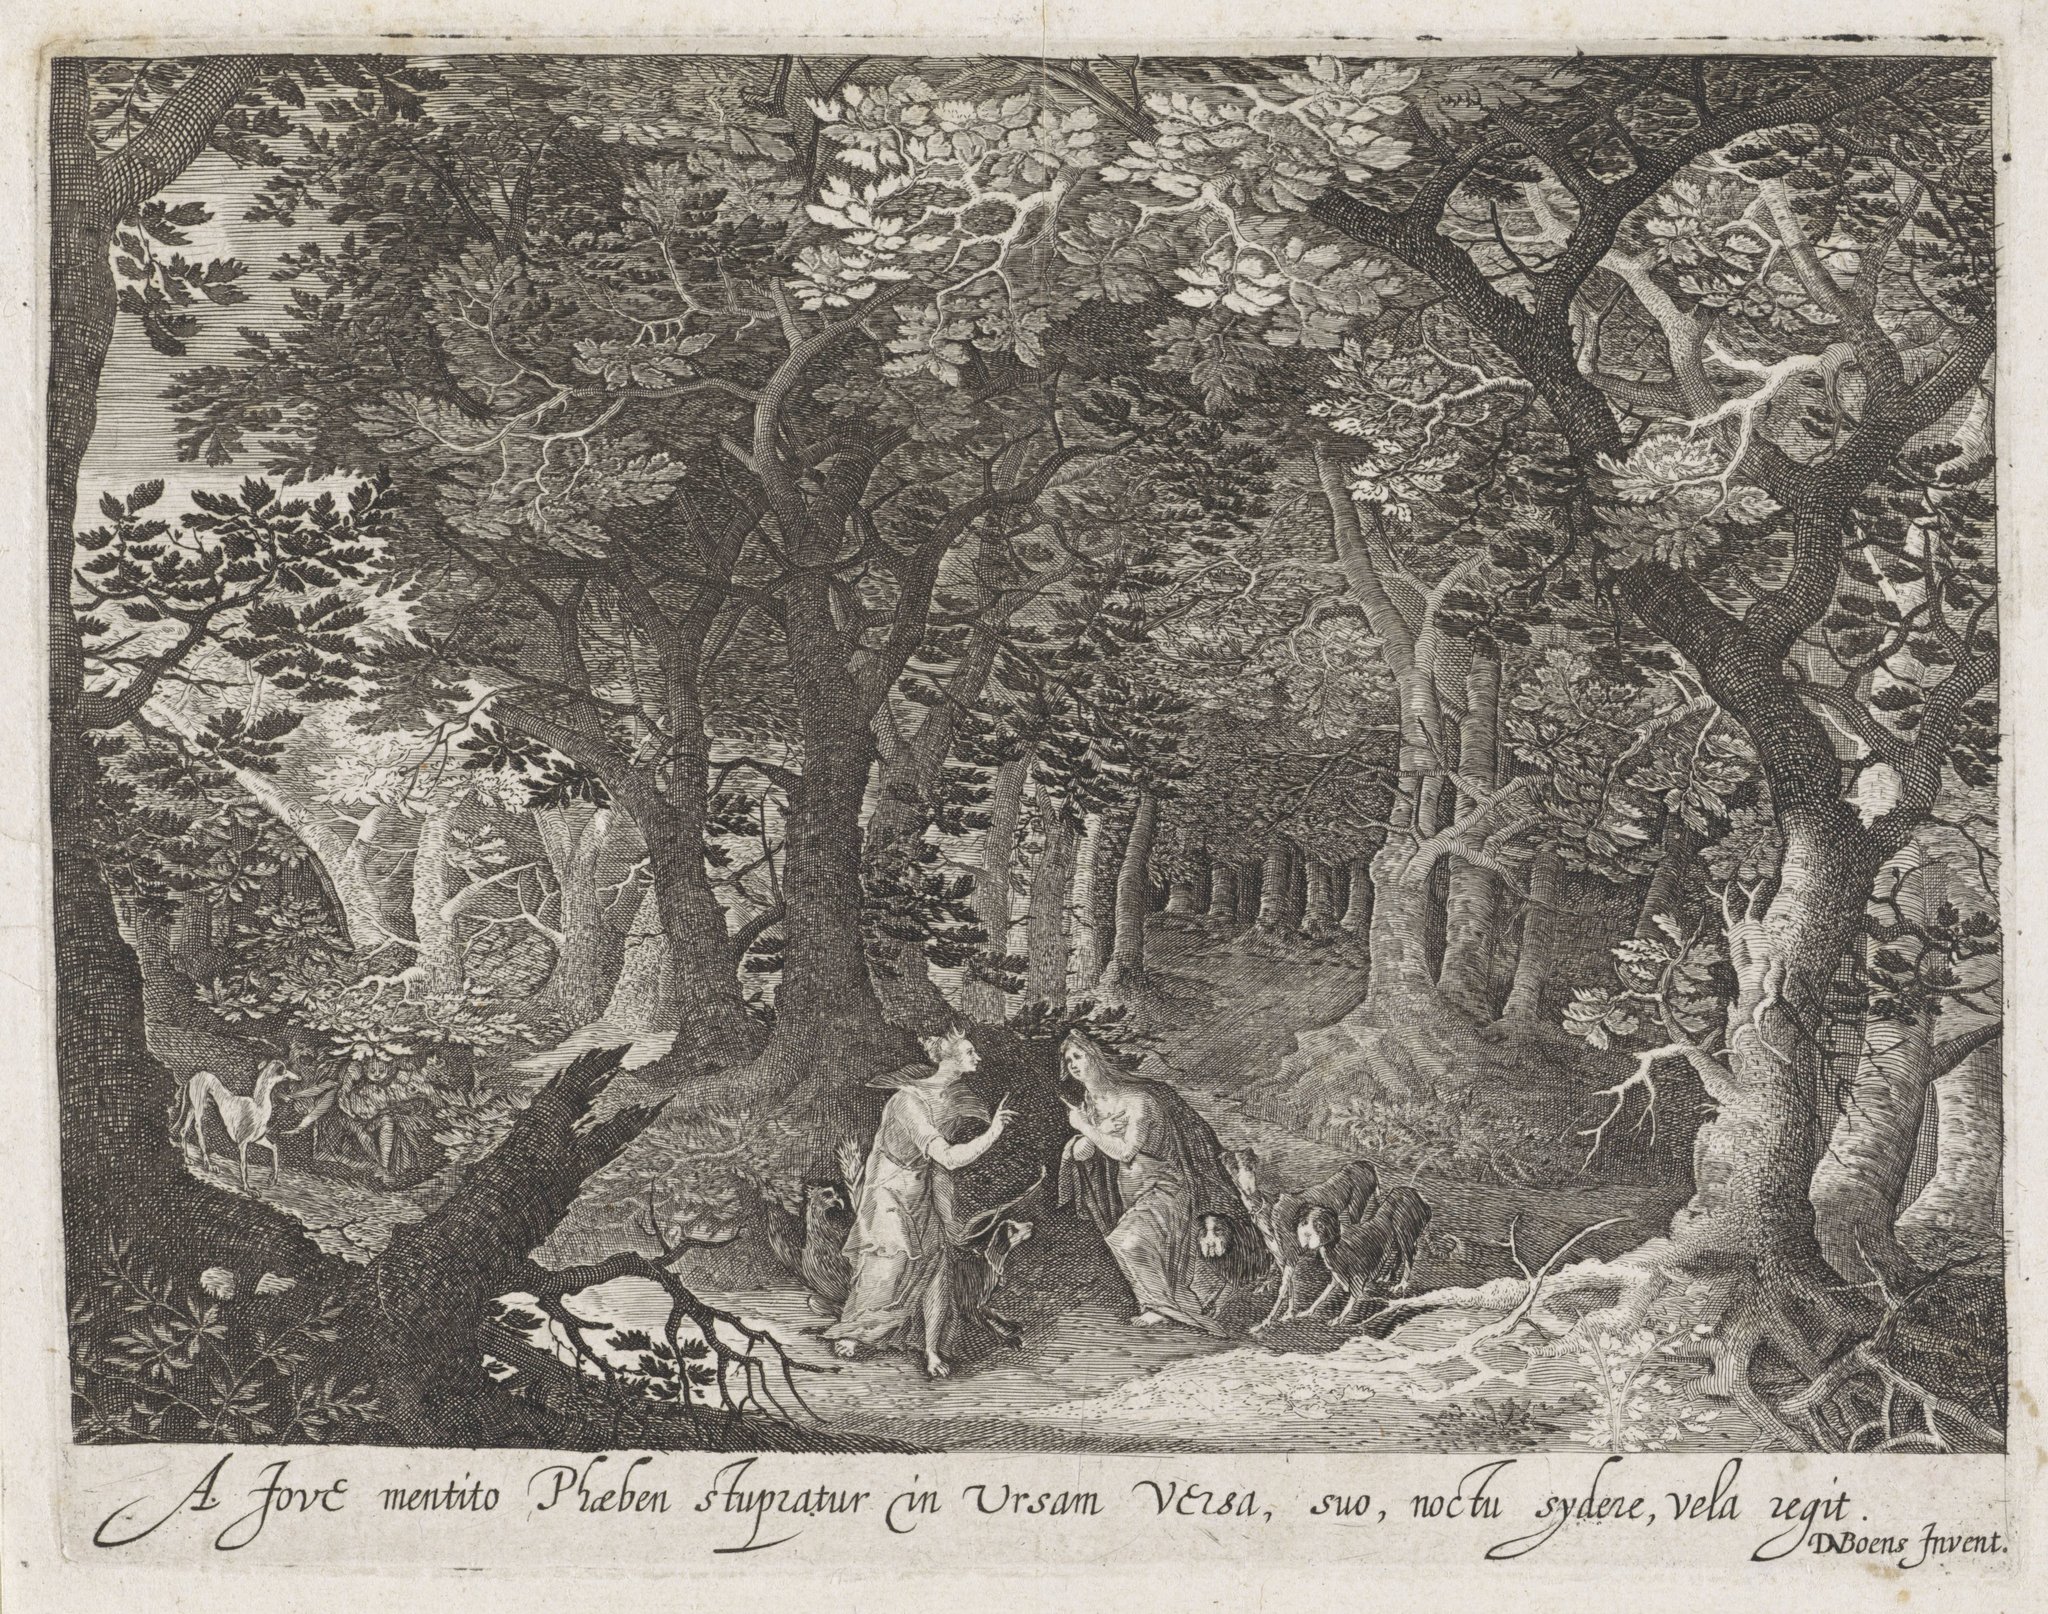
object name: print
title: Jupiter en Callisto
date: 1591-1679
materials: paper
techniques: engraving, etching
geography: low countries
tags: jupiter, in the guise of diana, and callisto, homosexual love - cc - homosexual love between women: lesbianism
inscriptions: collector's mark: Lugt 240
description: Op een bospad nadert Jupiter Callisto in de gedaante van Diana om haar te kunnen verleiden. Jupiter is te herkennen aan de adelaar naast hem. Callisto wordt door enkele jachthonden vergezeld. Onder een éénregelig onderschrift in het Latijn.